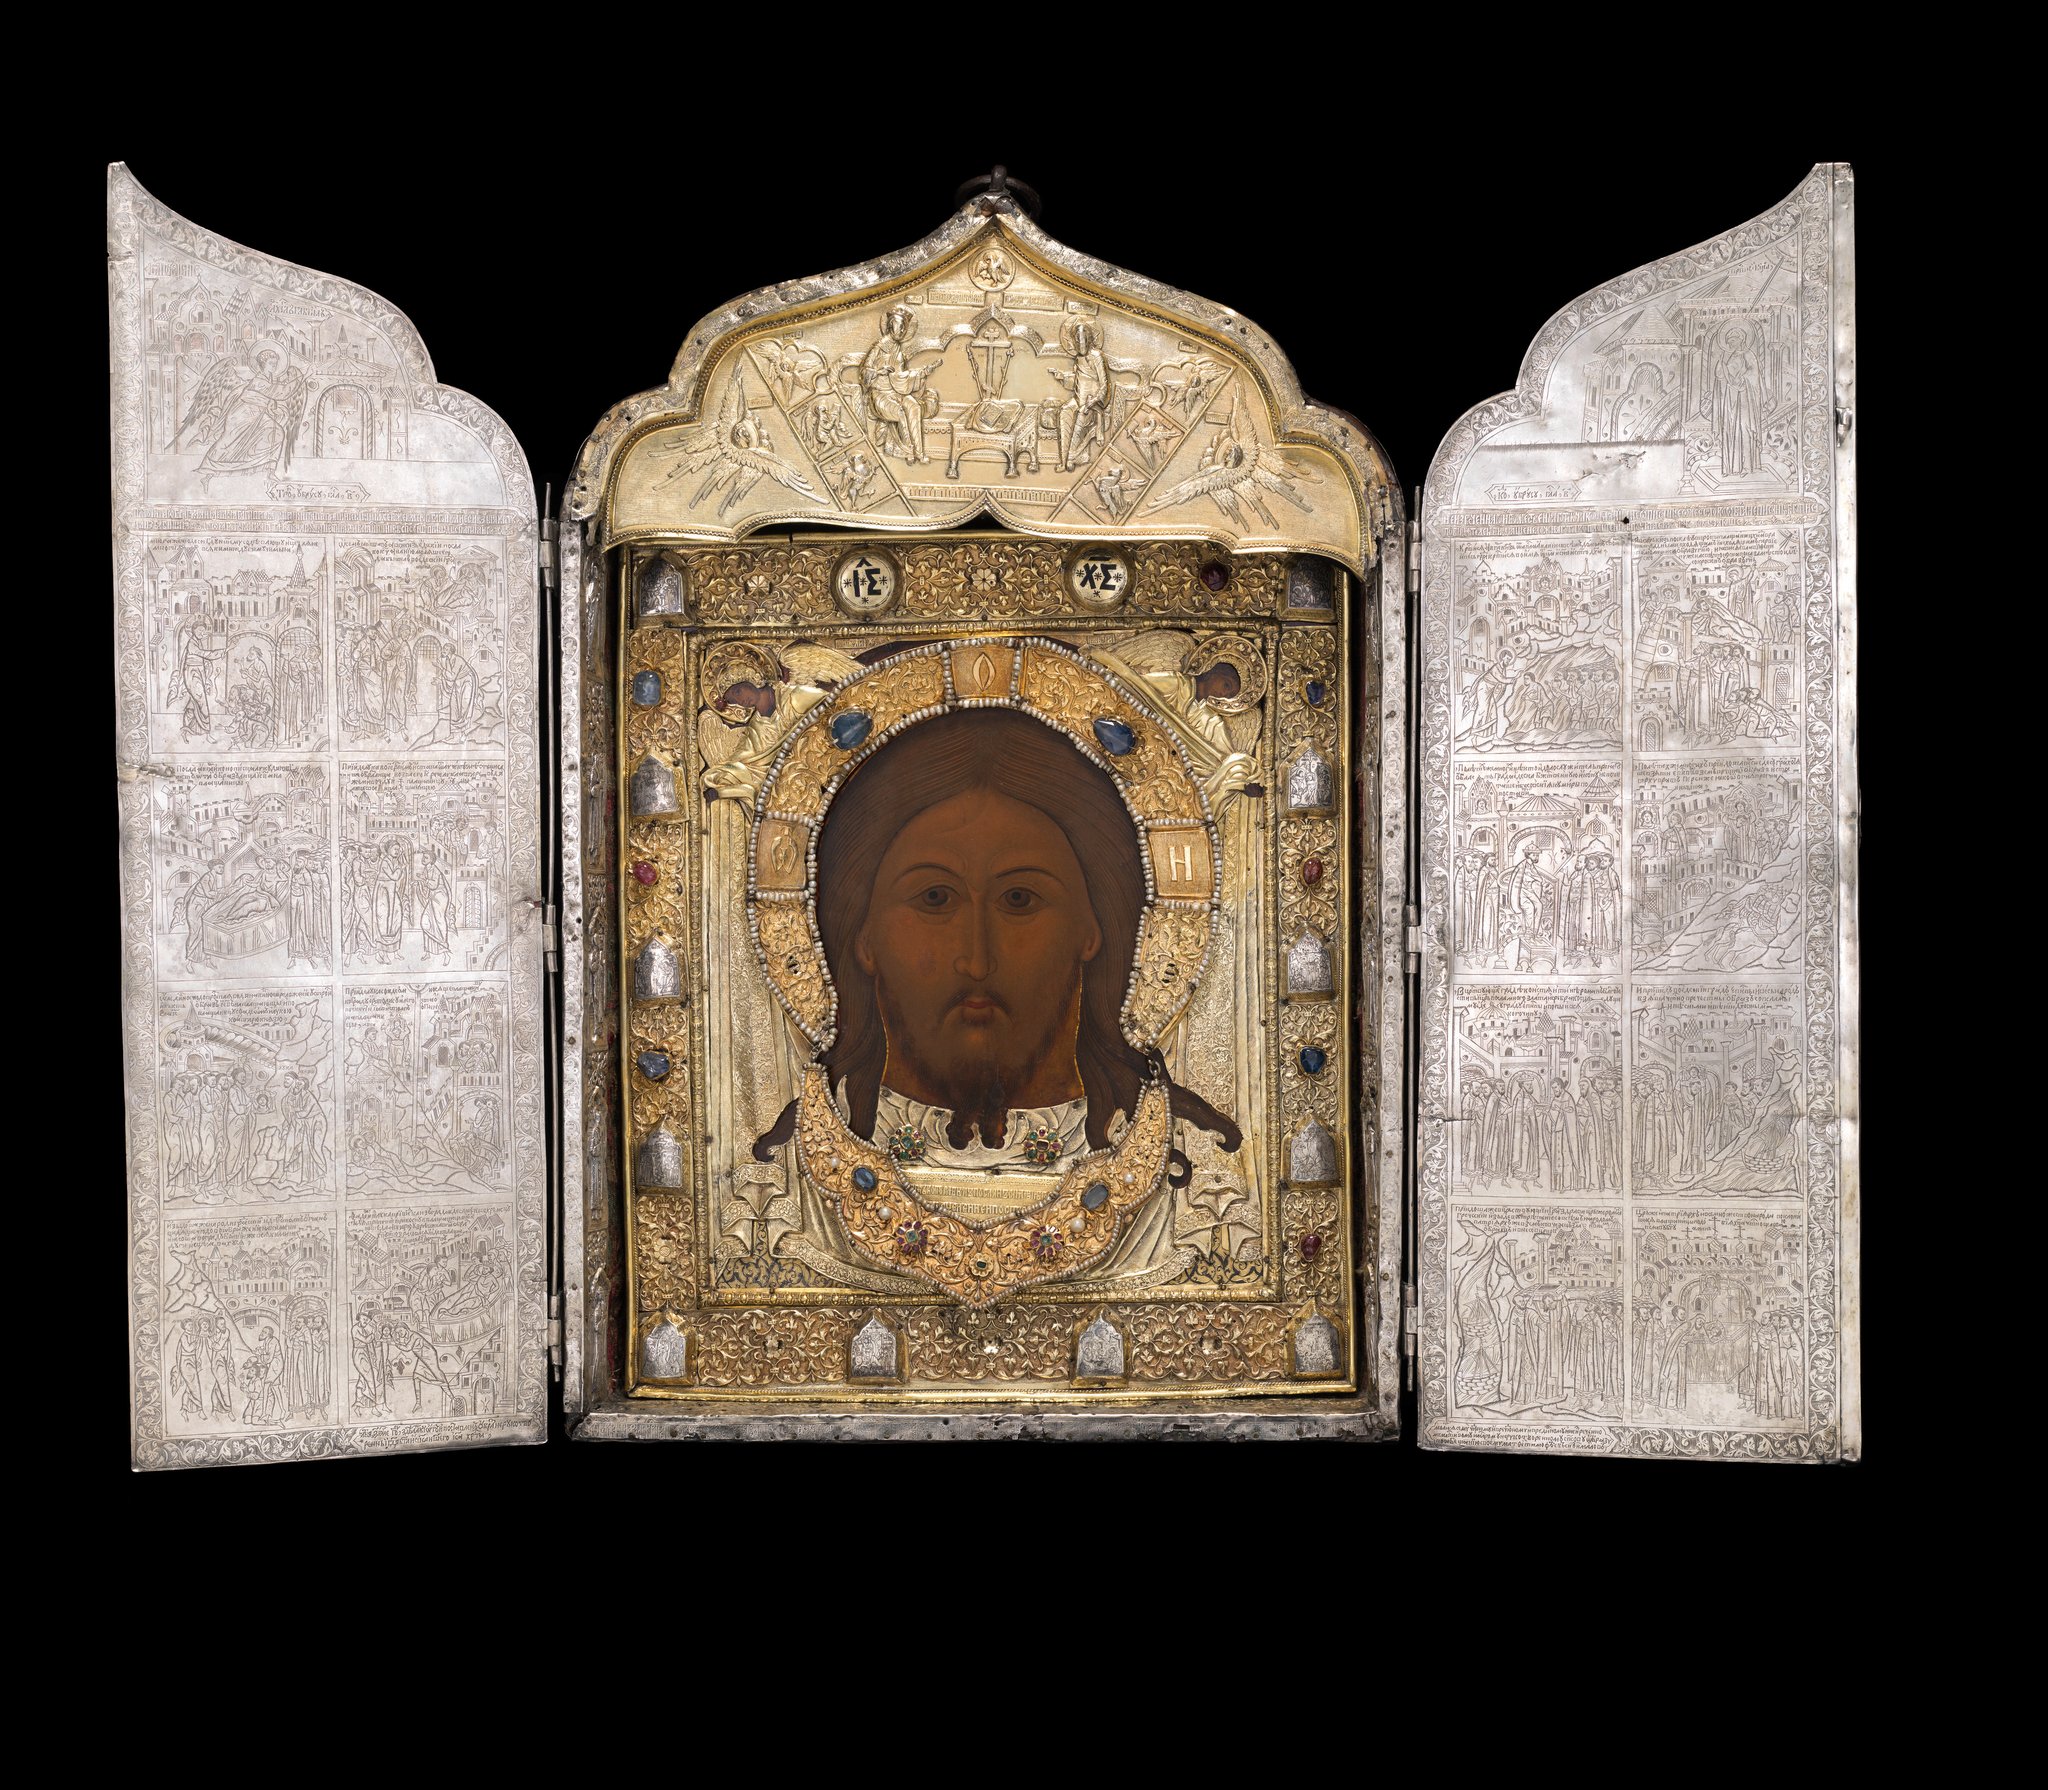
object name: triptych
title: Triptych with the Mandylion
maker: the kremlin armory workshops, moscow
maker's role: maker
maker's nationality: russian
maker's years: 1511-1715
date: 1637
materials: enamel, gesso, gilt, leather, linen, mica, niello, wood, oil, pearl, gemstone, silk, silver, skin, velvet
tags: angels,christ